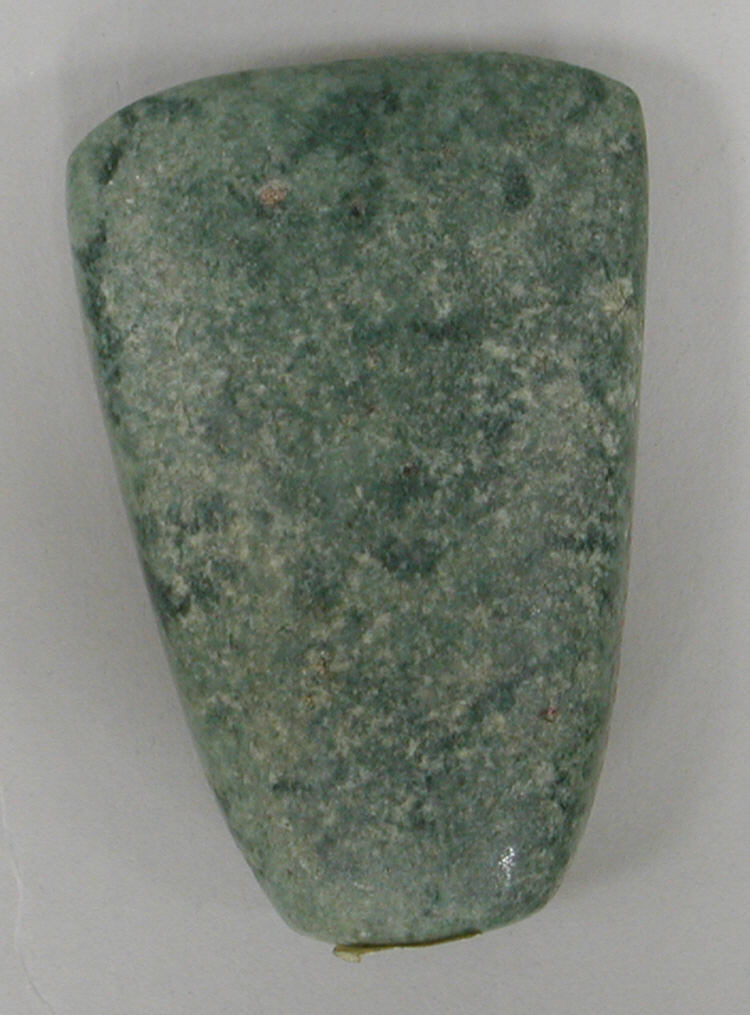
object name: celt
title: Stone Celt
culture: mexican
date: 1501-1600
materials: stone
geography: mexico